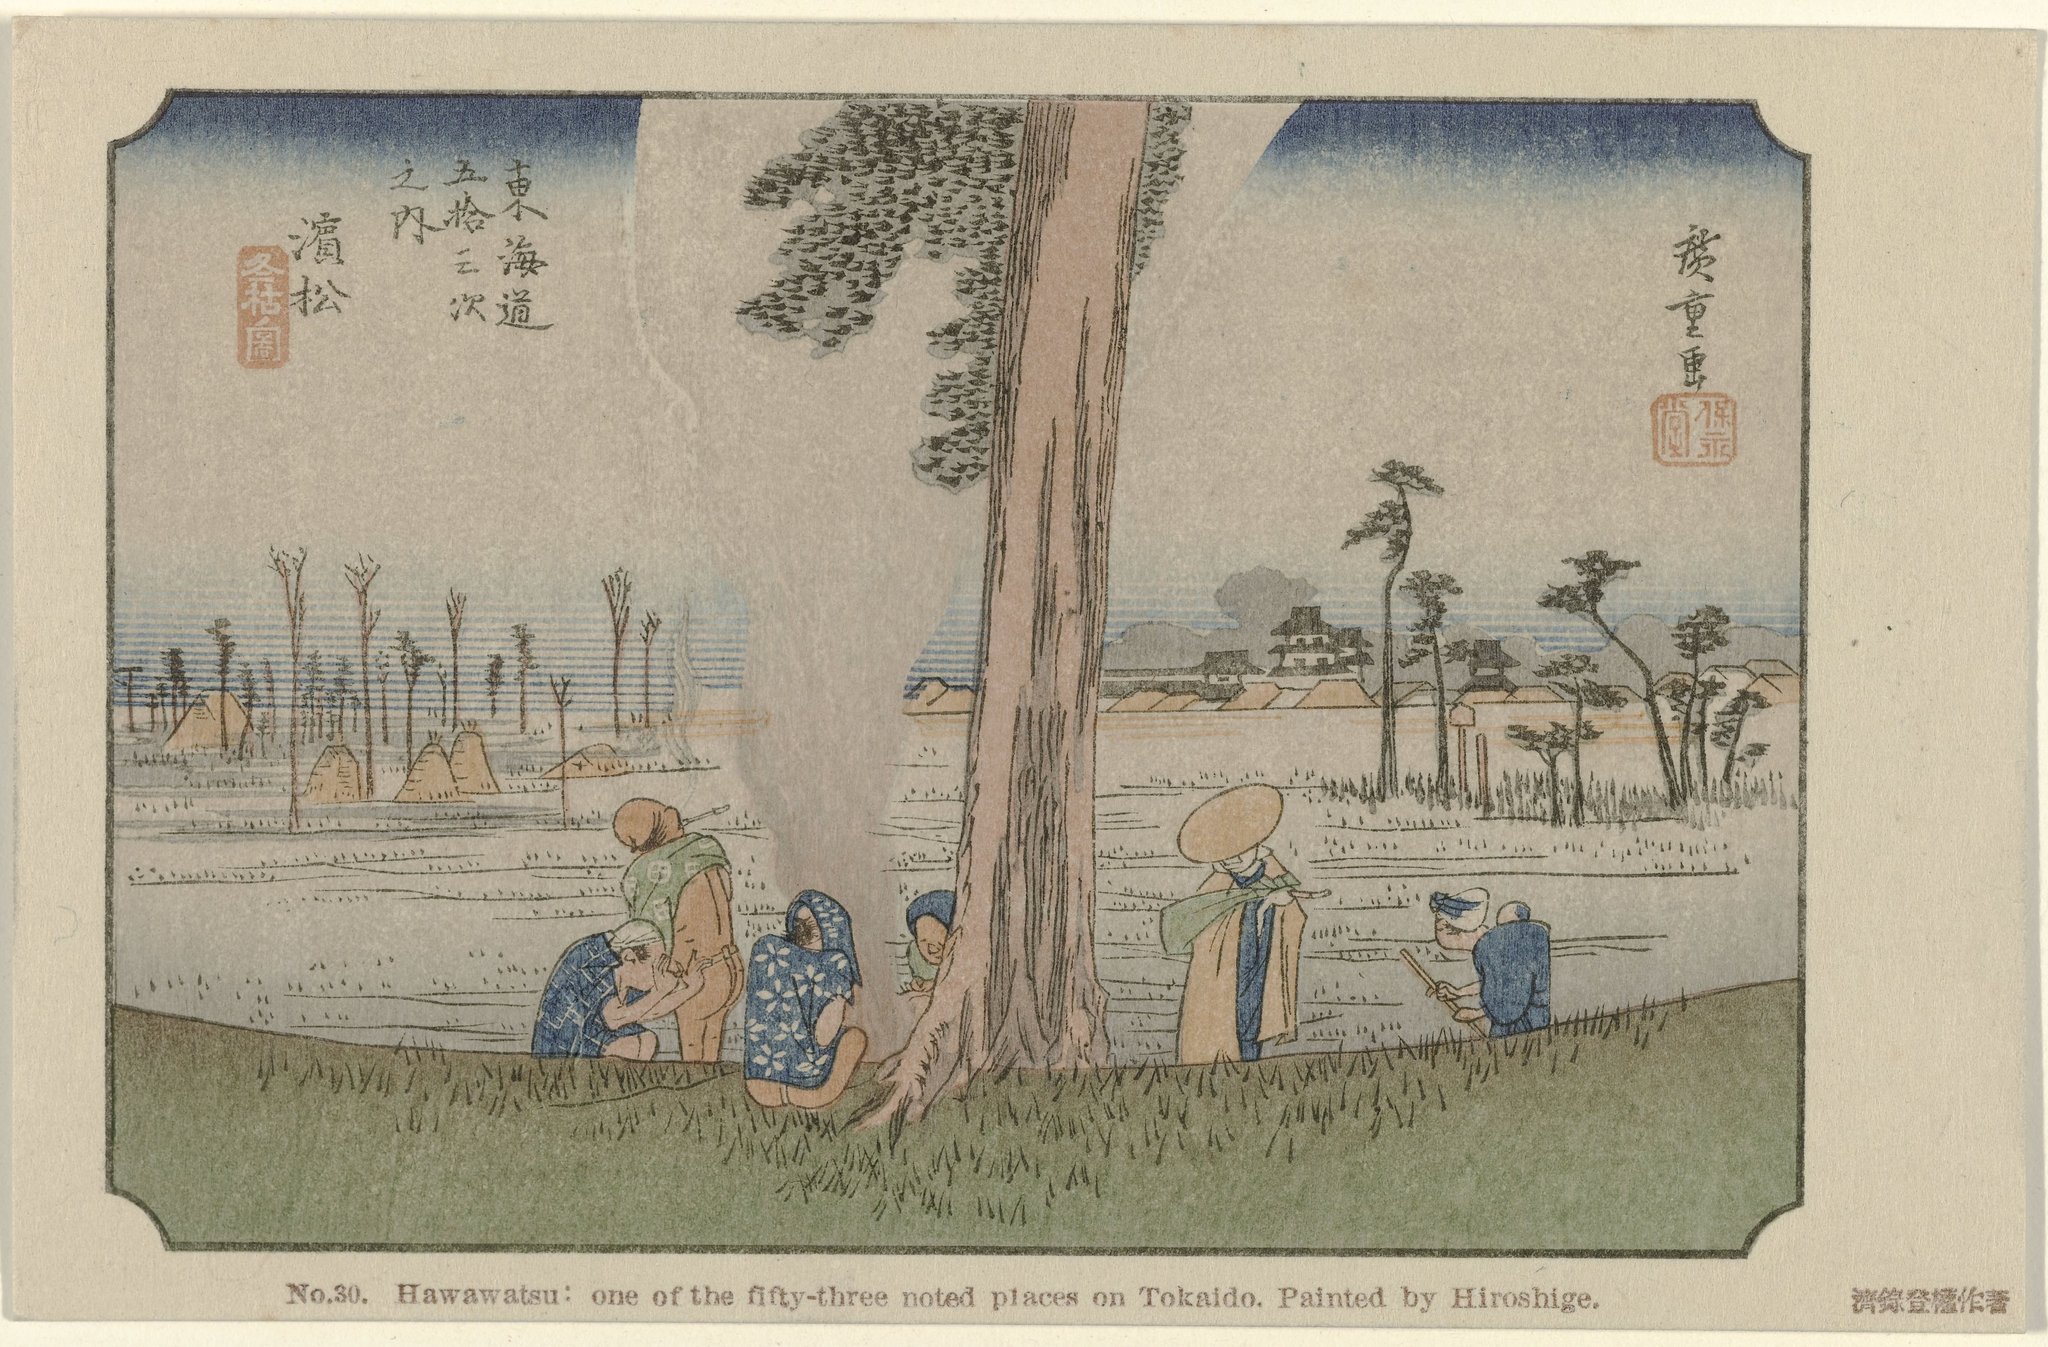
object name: ansichtkaart, prentbriefkaart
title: No. 30. Hawawatsu: one of the fifty-three noted places on Tokaido, painted by Hiroshige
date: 1906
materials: cardboard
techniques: woodcut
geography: japan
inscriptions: date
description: Een groepje bedienden warmen zich aan een vuurtje, met in de achtergrond kale rijstvelden.